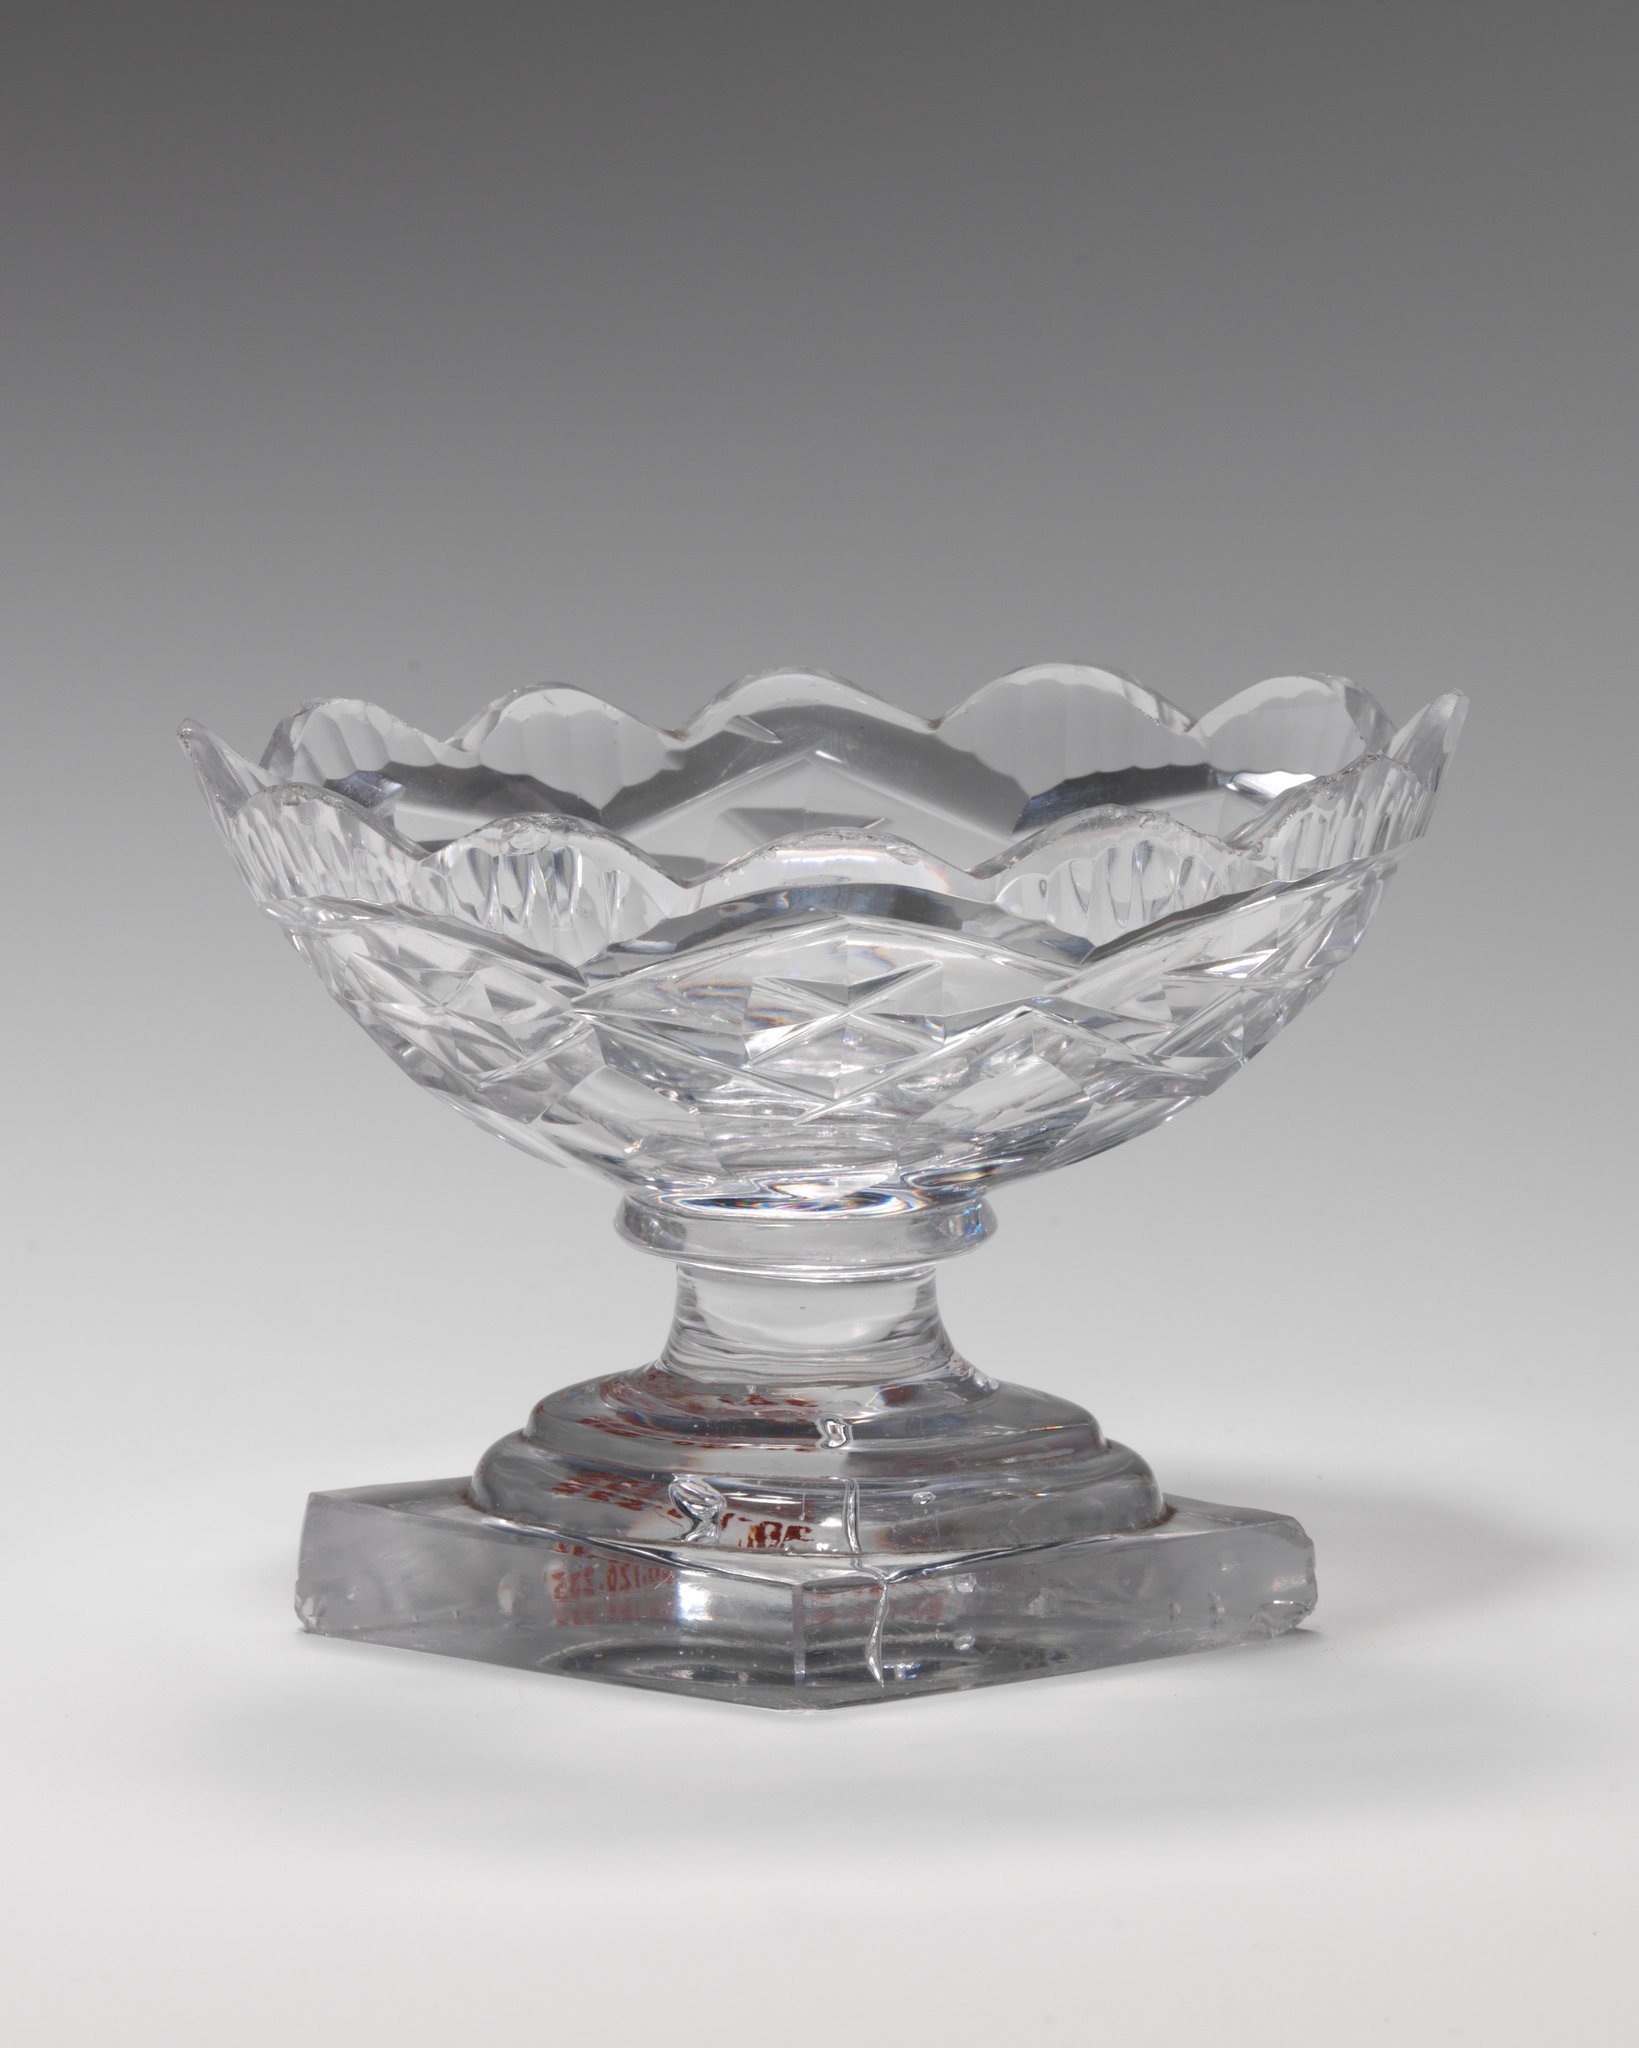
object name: salt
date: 1767-1800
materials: glass